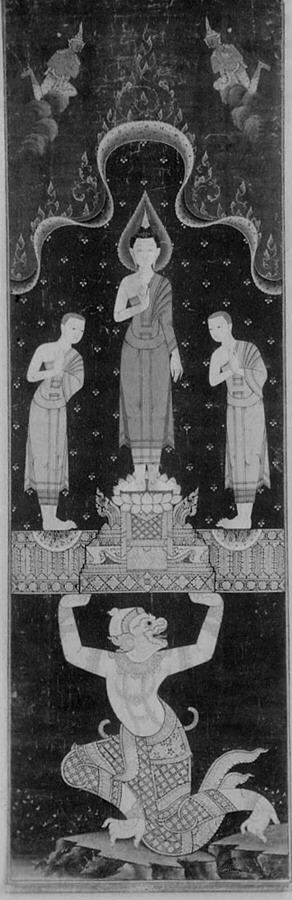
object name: hanging scroll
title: Buddhist Temple Painting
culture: thai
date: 1801-1833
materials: silk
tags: men,buddhism